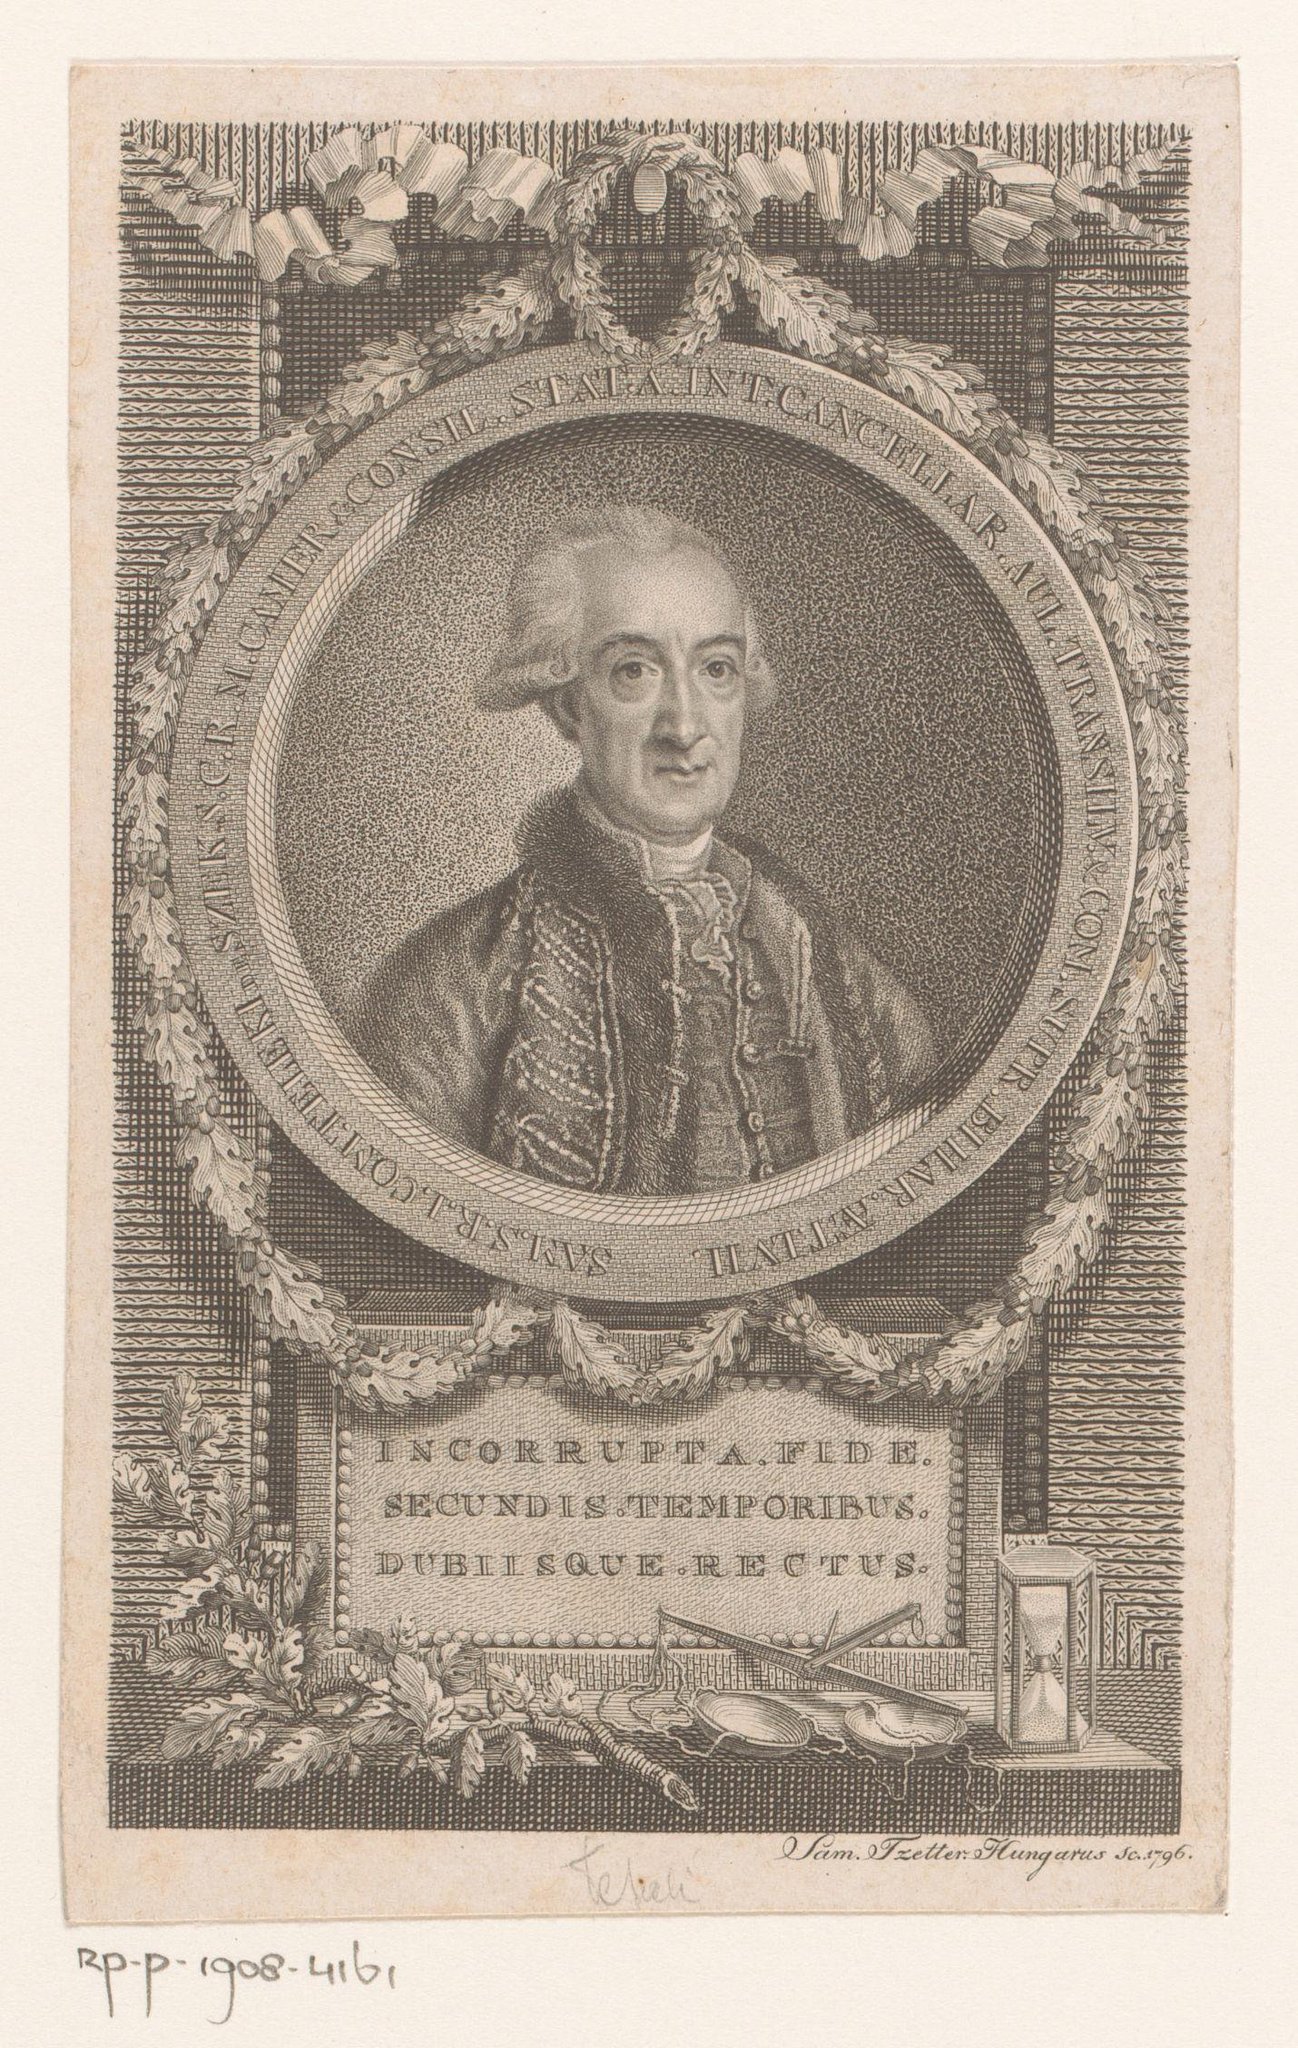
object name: print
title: Portret van graaf Sámuel Teleki de Szek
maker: samuel czetter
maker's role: print maker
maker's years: 1765-1829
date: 1796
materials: paper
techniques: etching, engraving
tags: vienna, historical persons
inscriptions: collector's mark: Lugt 2228